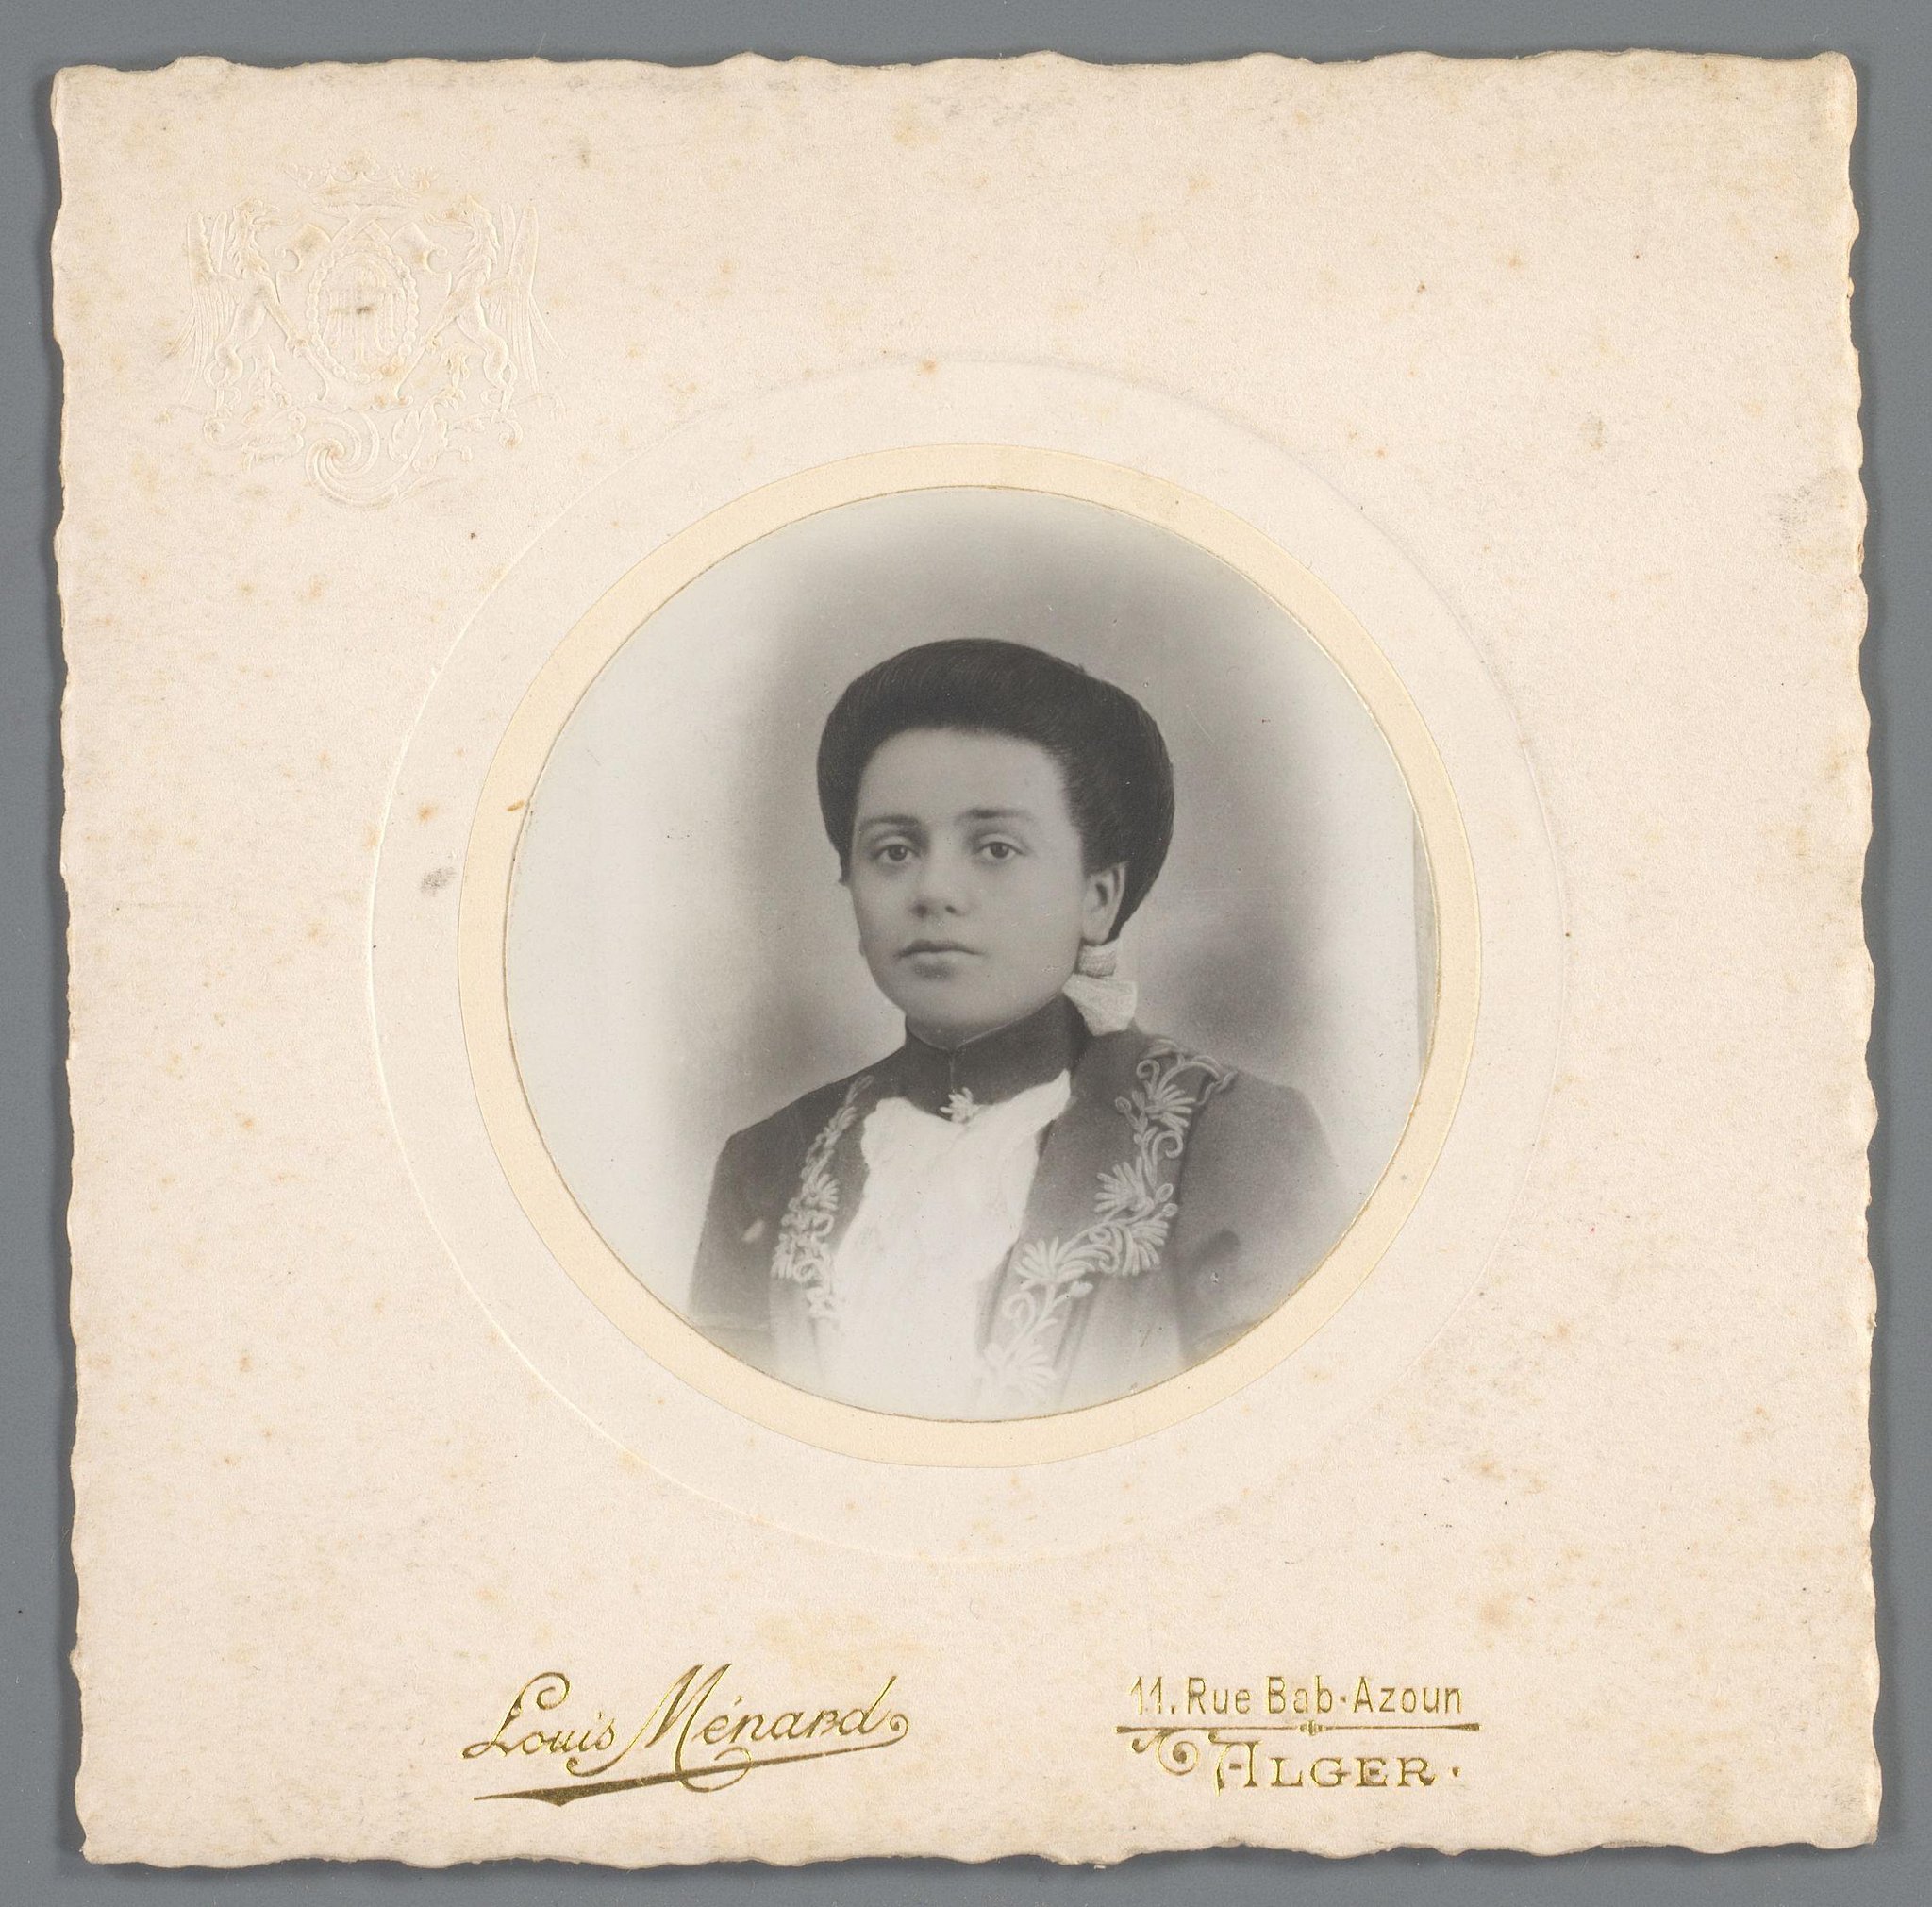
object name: photograph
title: Portret van een onbekende vrouw, aangeduid als Henriette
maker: louis ménard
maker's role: dichter, filosoof, fotograaf, historicus, journalist, schrijver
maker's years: 1822-1901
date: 1902-1915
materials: cardboard, photographic support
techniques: gelatin silver print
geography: algiers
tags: historical persons - bb - woman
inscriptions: address: ‘Louis Ménard/ 11. Rue Bab-Azoun/ALGER.’, inscription: ‘Clouveuir de aia/ pauve auayran/ Henriette/ Fevrier 1915’